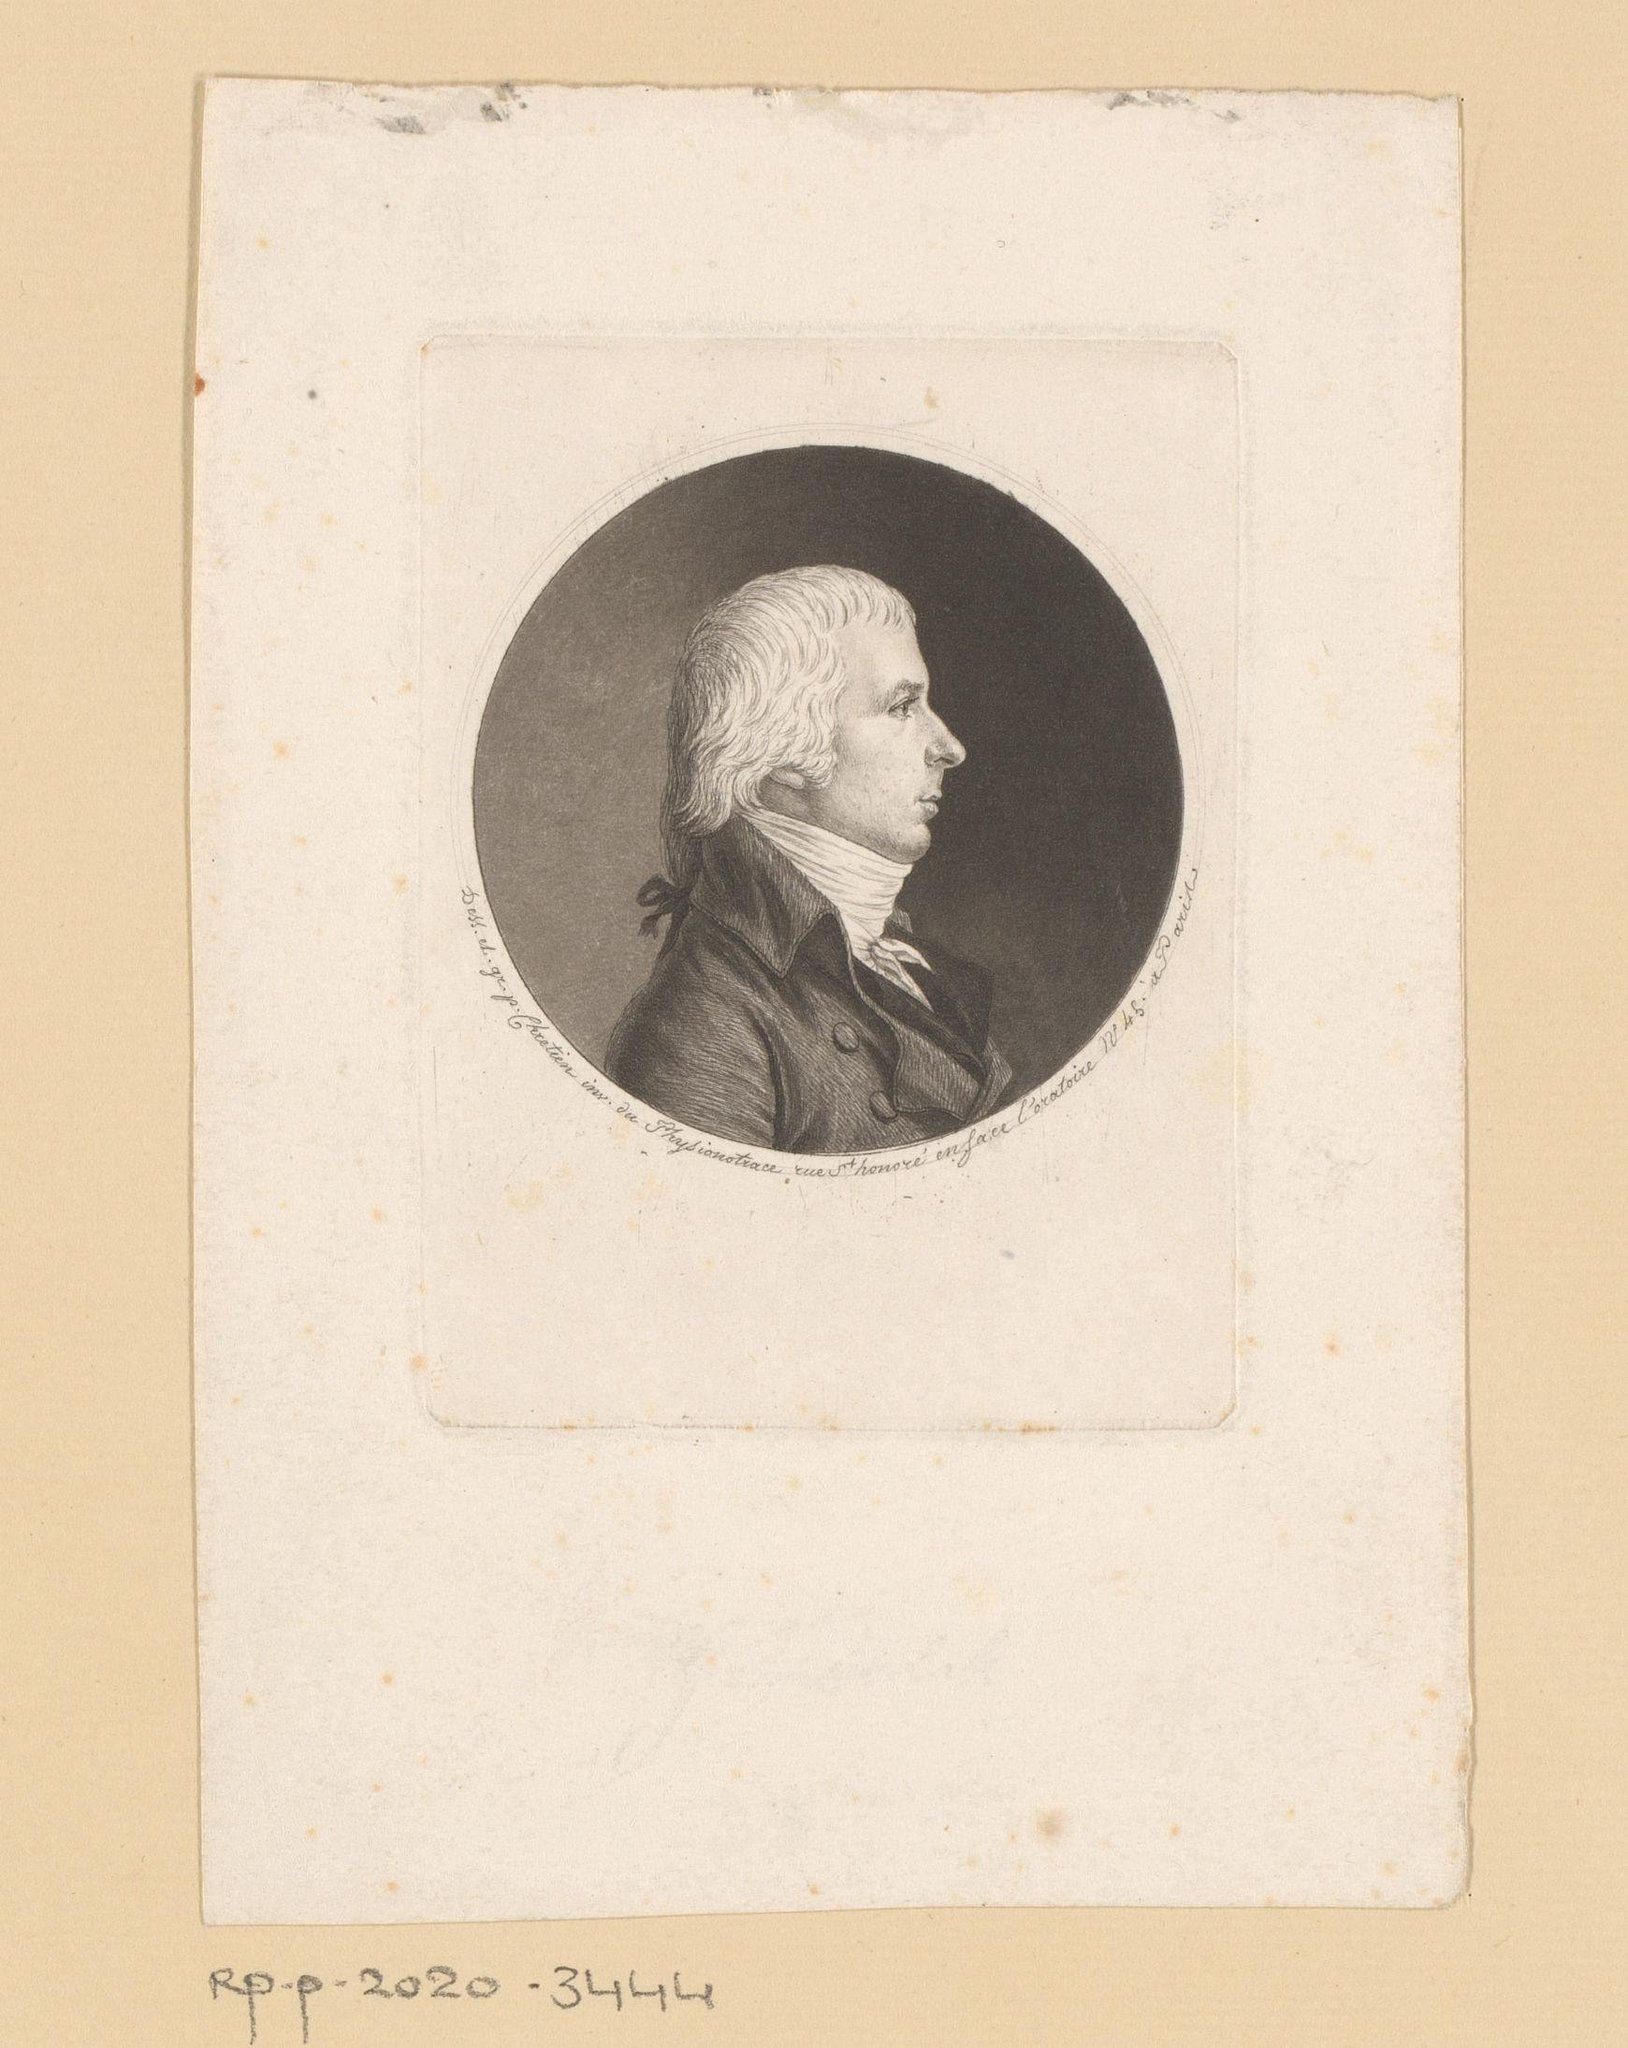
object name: print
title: Portret van Gerardus Vrolik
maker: gilles louis chrétien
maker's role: print maker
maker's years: 1754-1811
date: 1785-1811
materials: paper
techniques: aquatint, etching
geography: paris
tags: silhouette-apparatus, 'physionotrace', historical persons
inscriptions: collector's mark: Lugt 2227